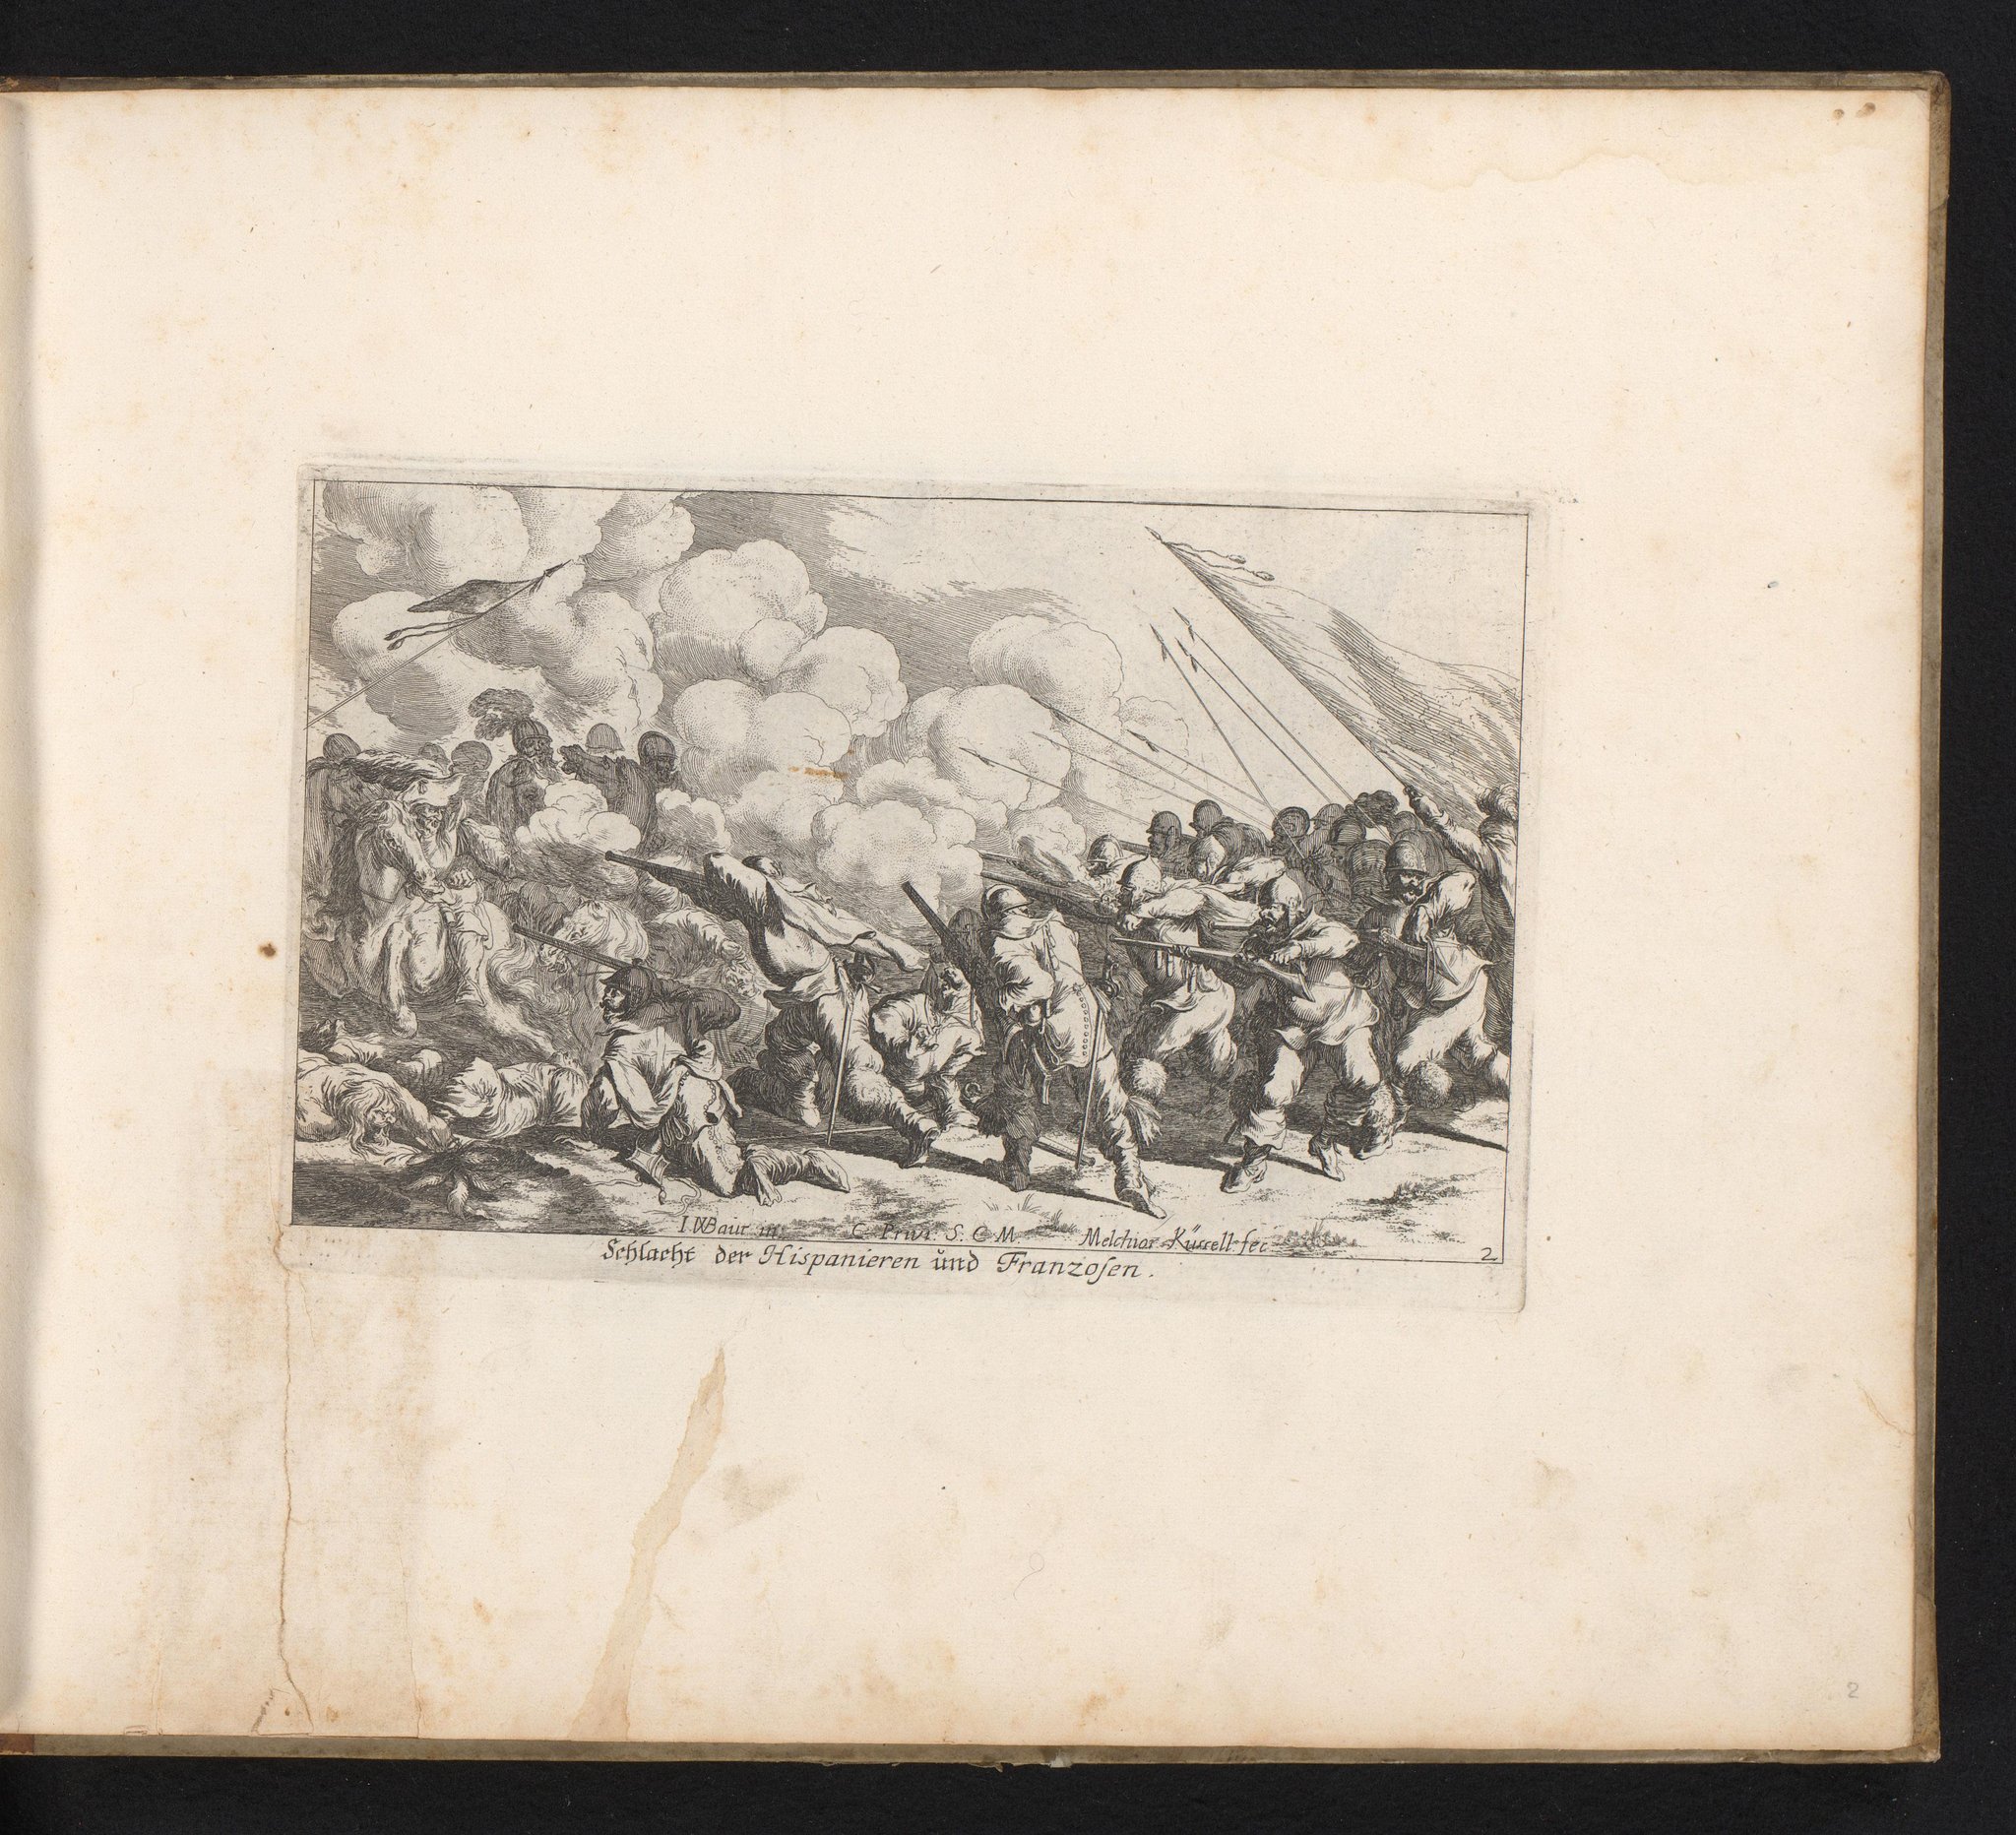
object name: print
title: Gevecht tussen Spanjaarden en Fransen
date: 1670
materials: paper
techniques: etching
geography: augsburg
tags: charge ~ battle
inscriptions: collector's mark: Lugt 2228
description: Tekst in het Duits in de ondermarge. Rechtsonder genummerd: 2. Prent maakt deel uit van een album.